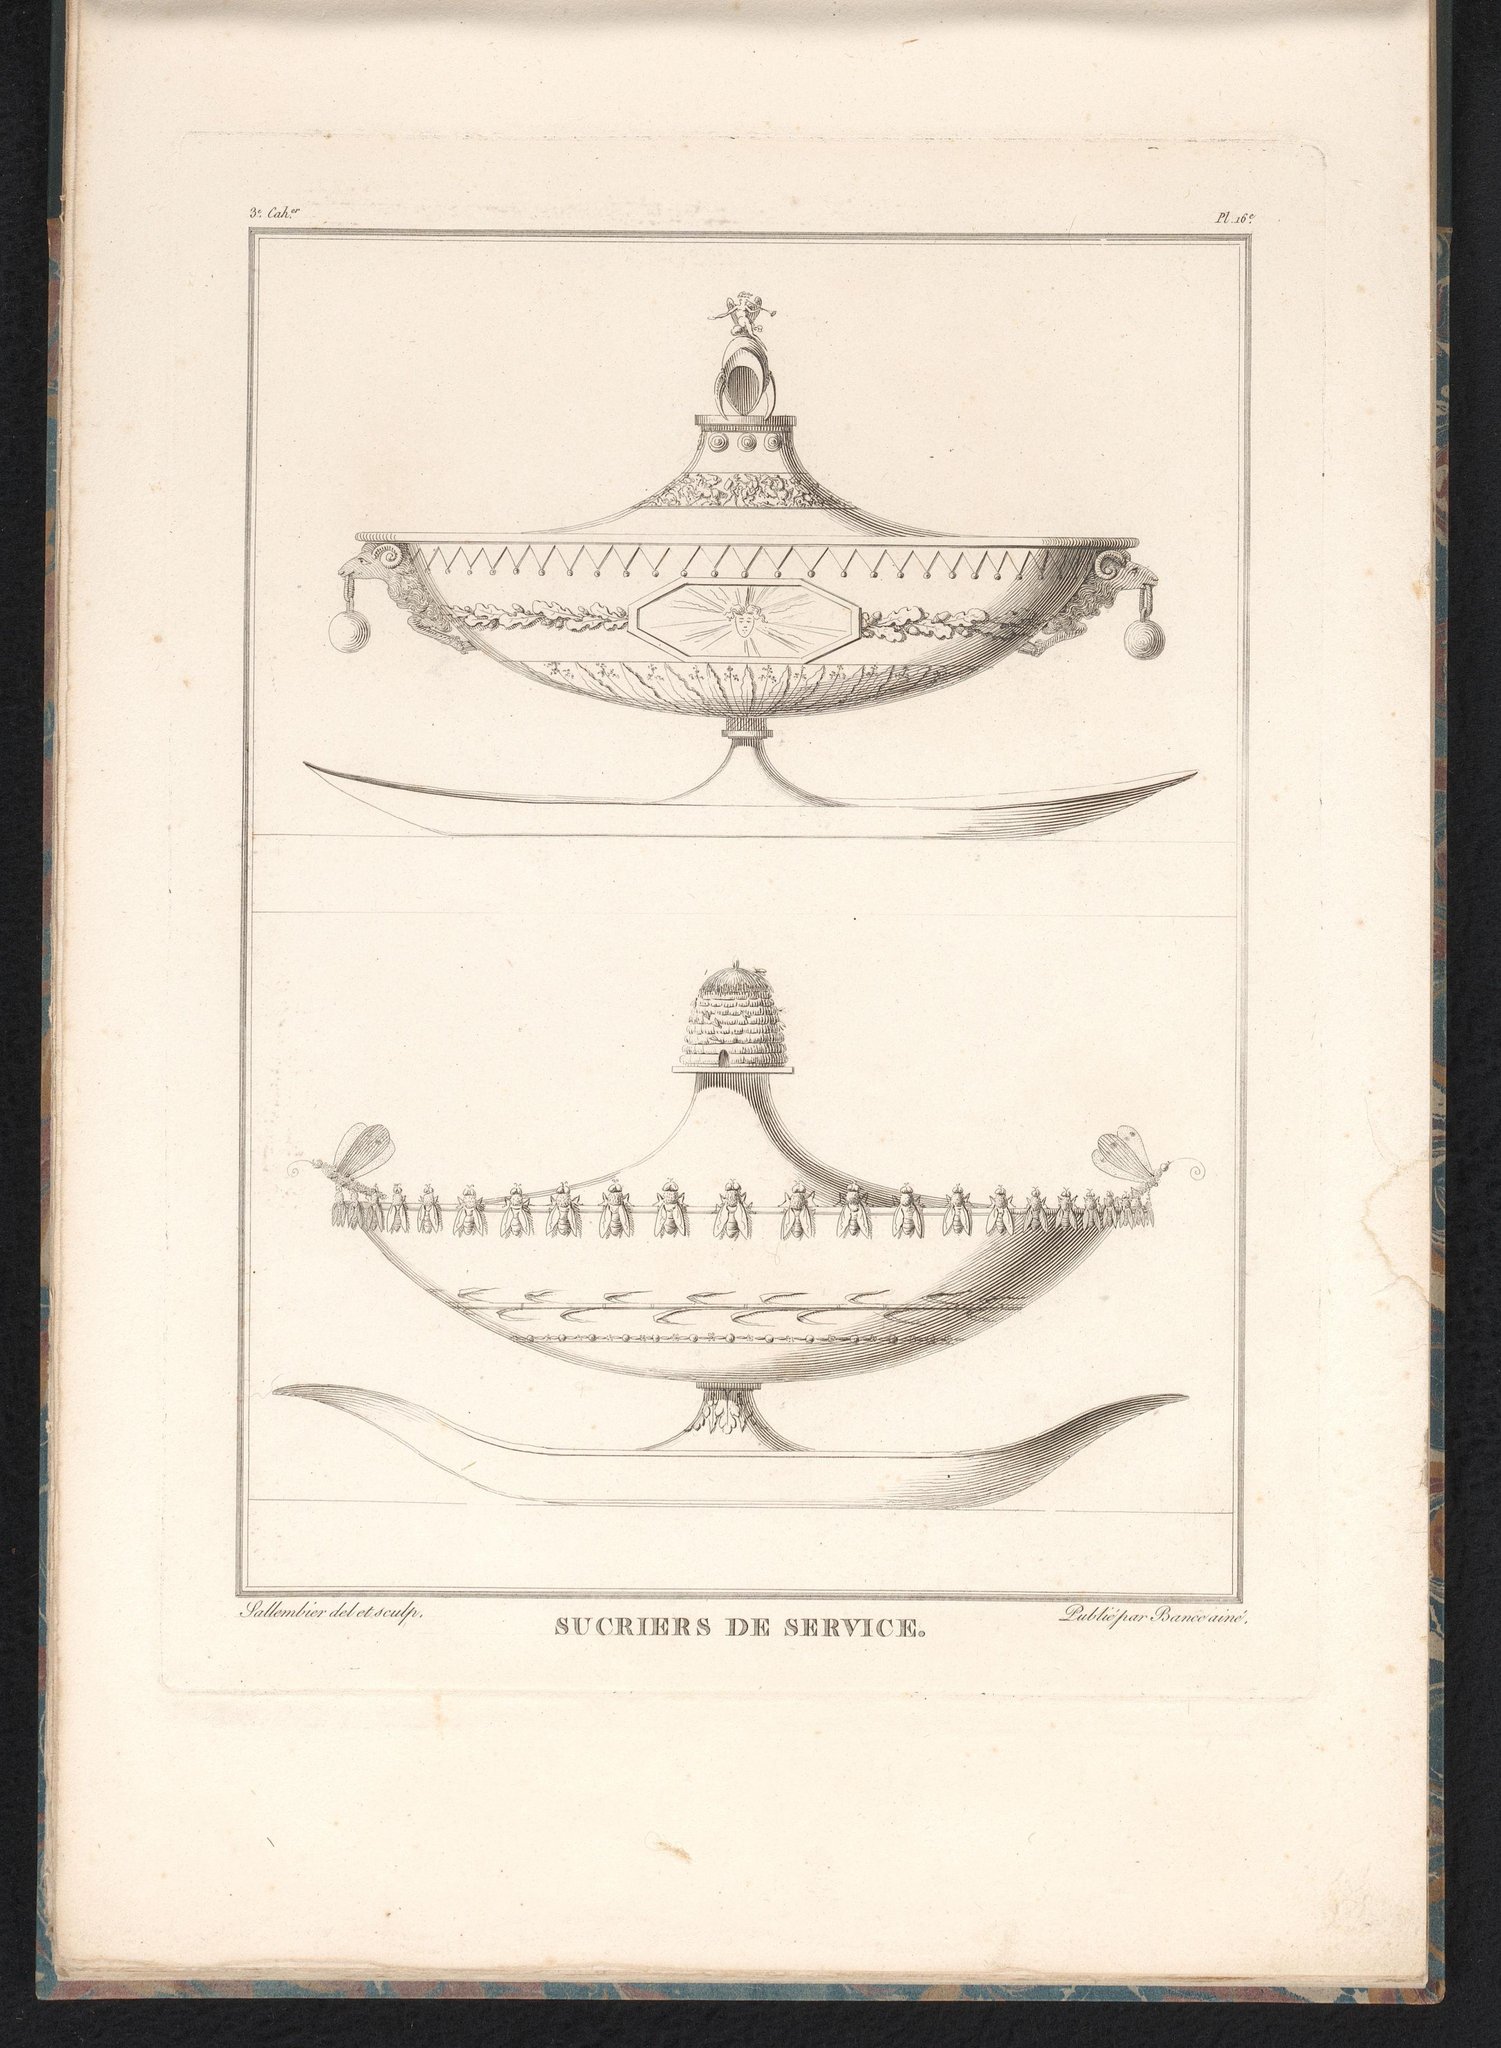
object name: ornament print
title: Modèles d'Orfèvrerie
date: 1805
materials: paper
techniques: etching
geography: paris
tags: sugar-basin, (story of) apollo (phoebus), bee-hive, insects: bee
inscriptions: number: ‘3.e Cah.er’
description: Ontwerpen voor een suikerschaal met Apollo. Eronder een ontwerp voor een suikerschaal met bijen en een bijenkorf. Prent maakt deel uit van een album.